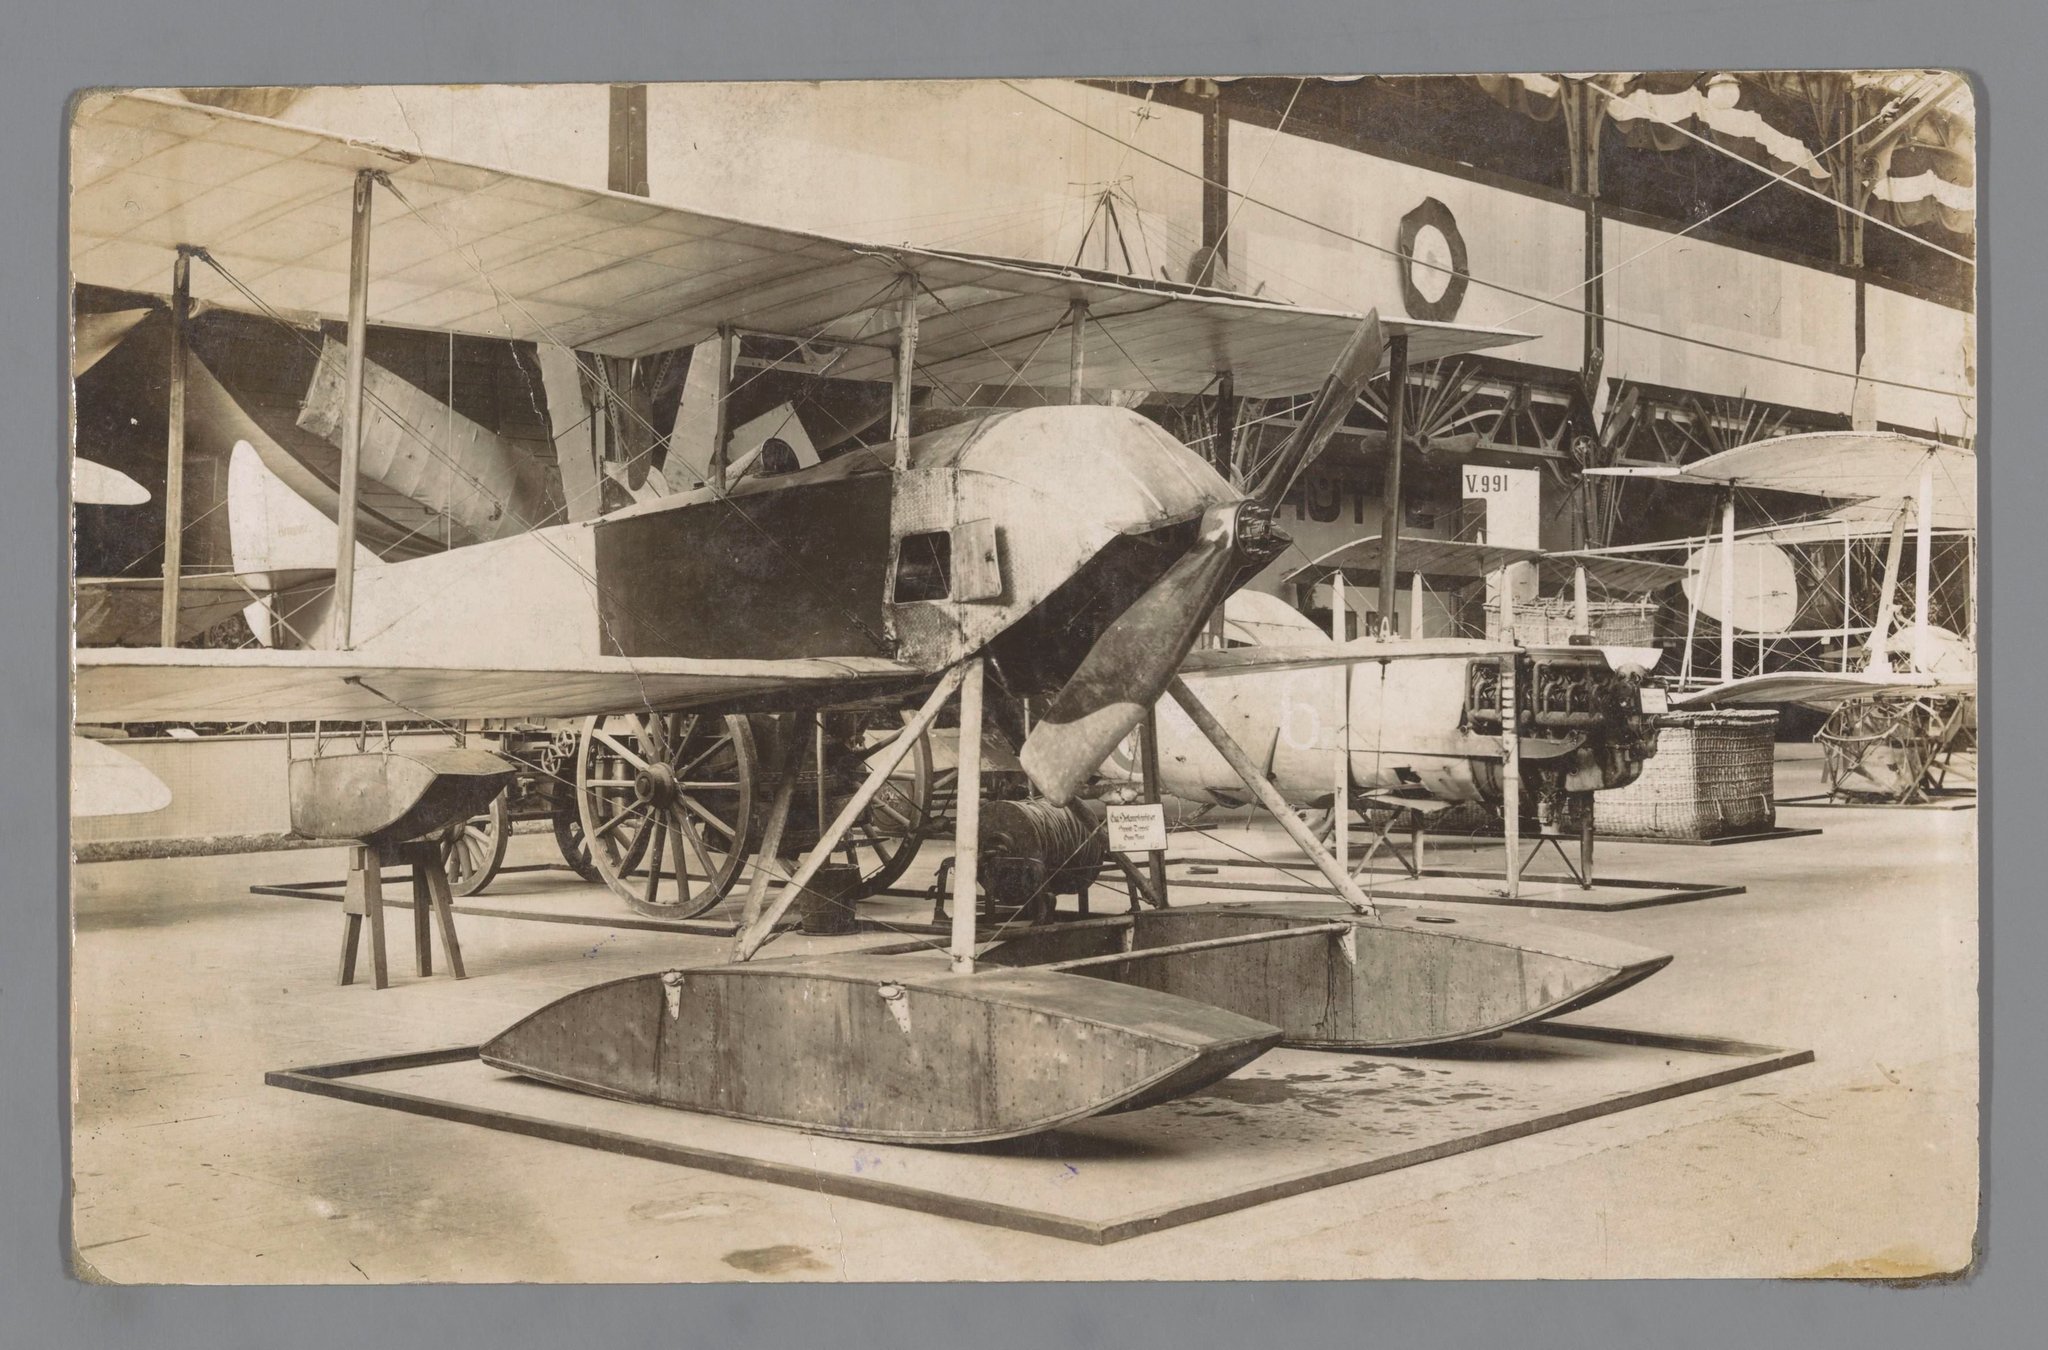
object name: photograph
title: Watervliegtuig in een hal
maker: Anonymous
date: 1917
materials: photographic support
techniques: gelatin silver print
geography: berlin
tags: aircraft, aeroplane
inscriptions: inscription: ‘"Luftfahrerdank"’, inscription: ‘Erinnerung an [...] Ausstellung (Delta) am zoo. 1917. (...) Berlin’